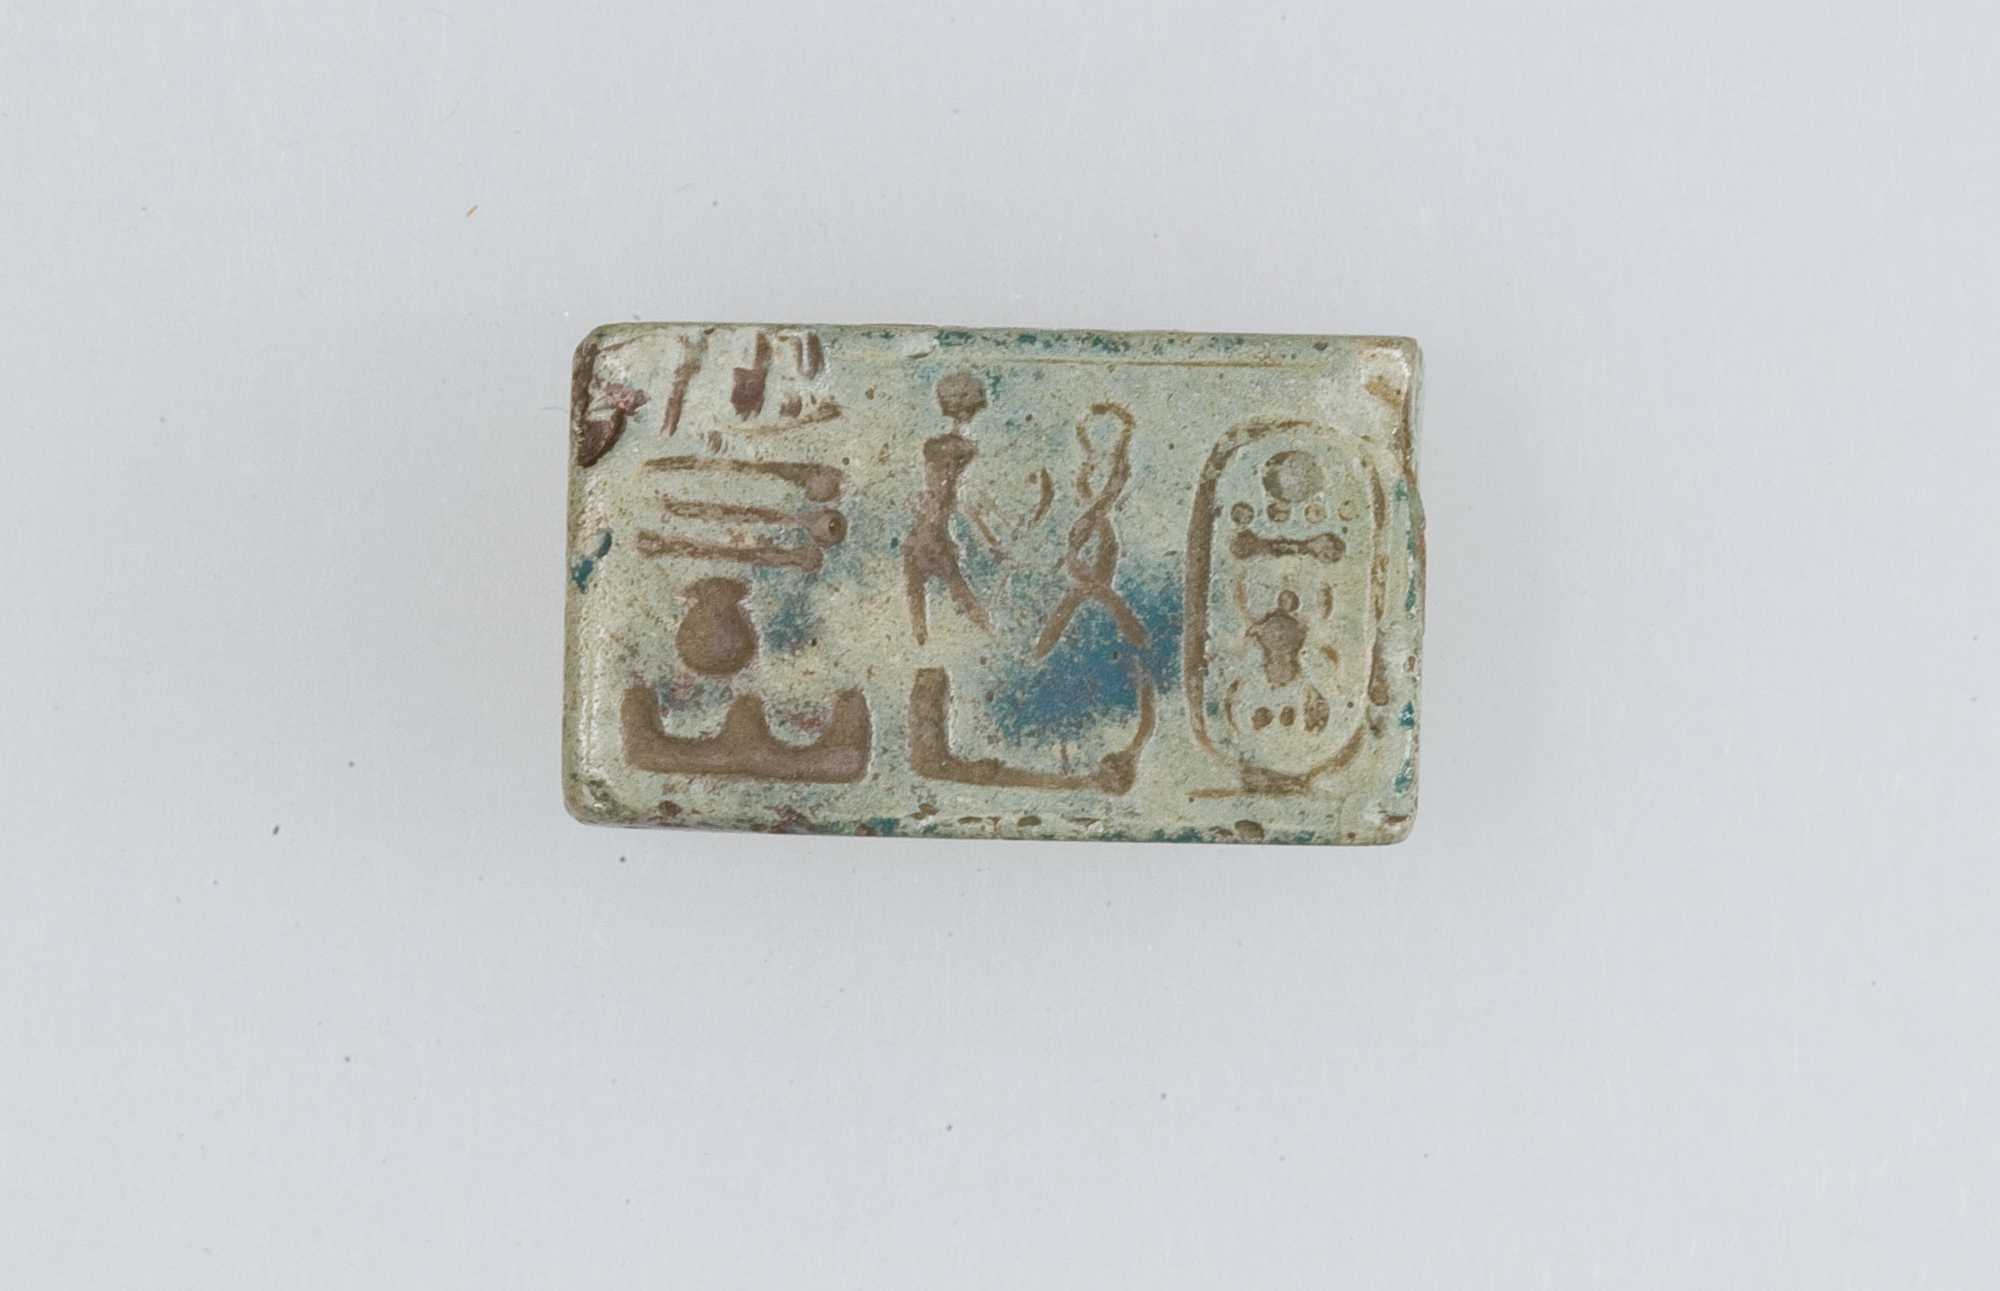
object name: plaque, thutmose iv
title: Plaque with the Throne Name of Thutmose IV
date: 1400-1390 BCE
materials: glass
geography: egypt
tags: hieroglyphs